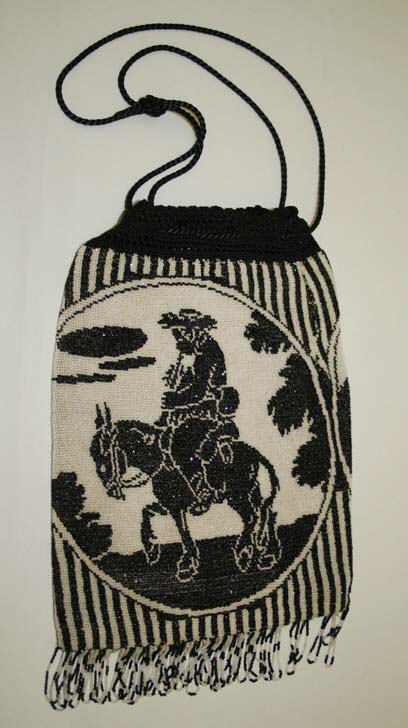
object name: drawstring bag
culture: european, eastern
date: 1904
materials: glass, silk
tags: men,donkeys